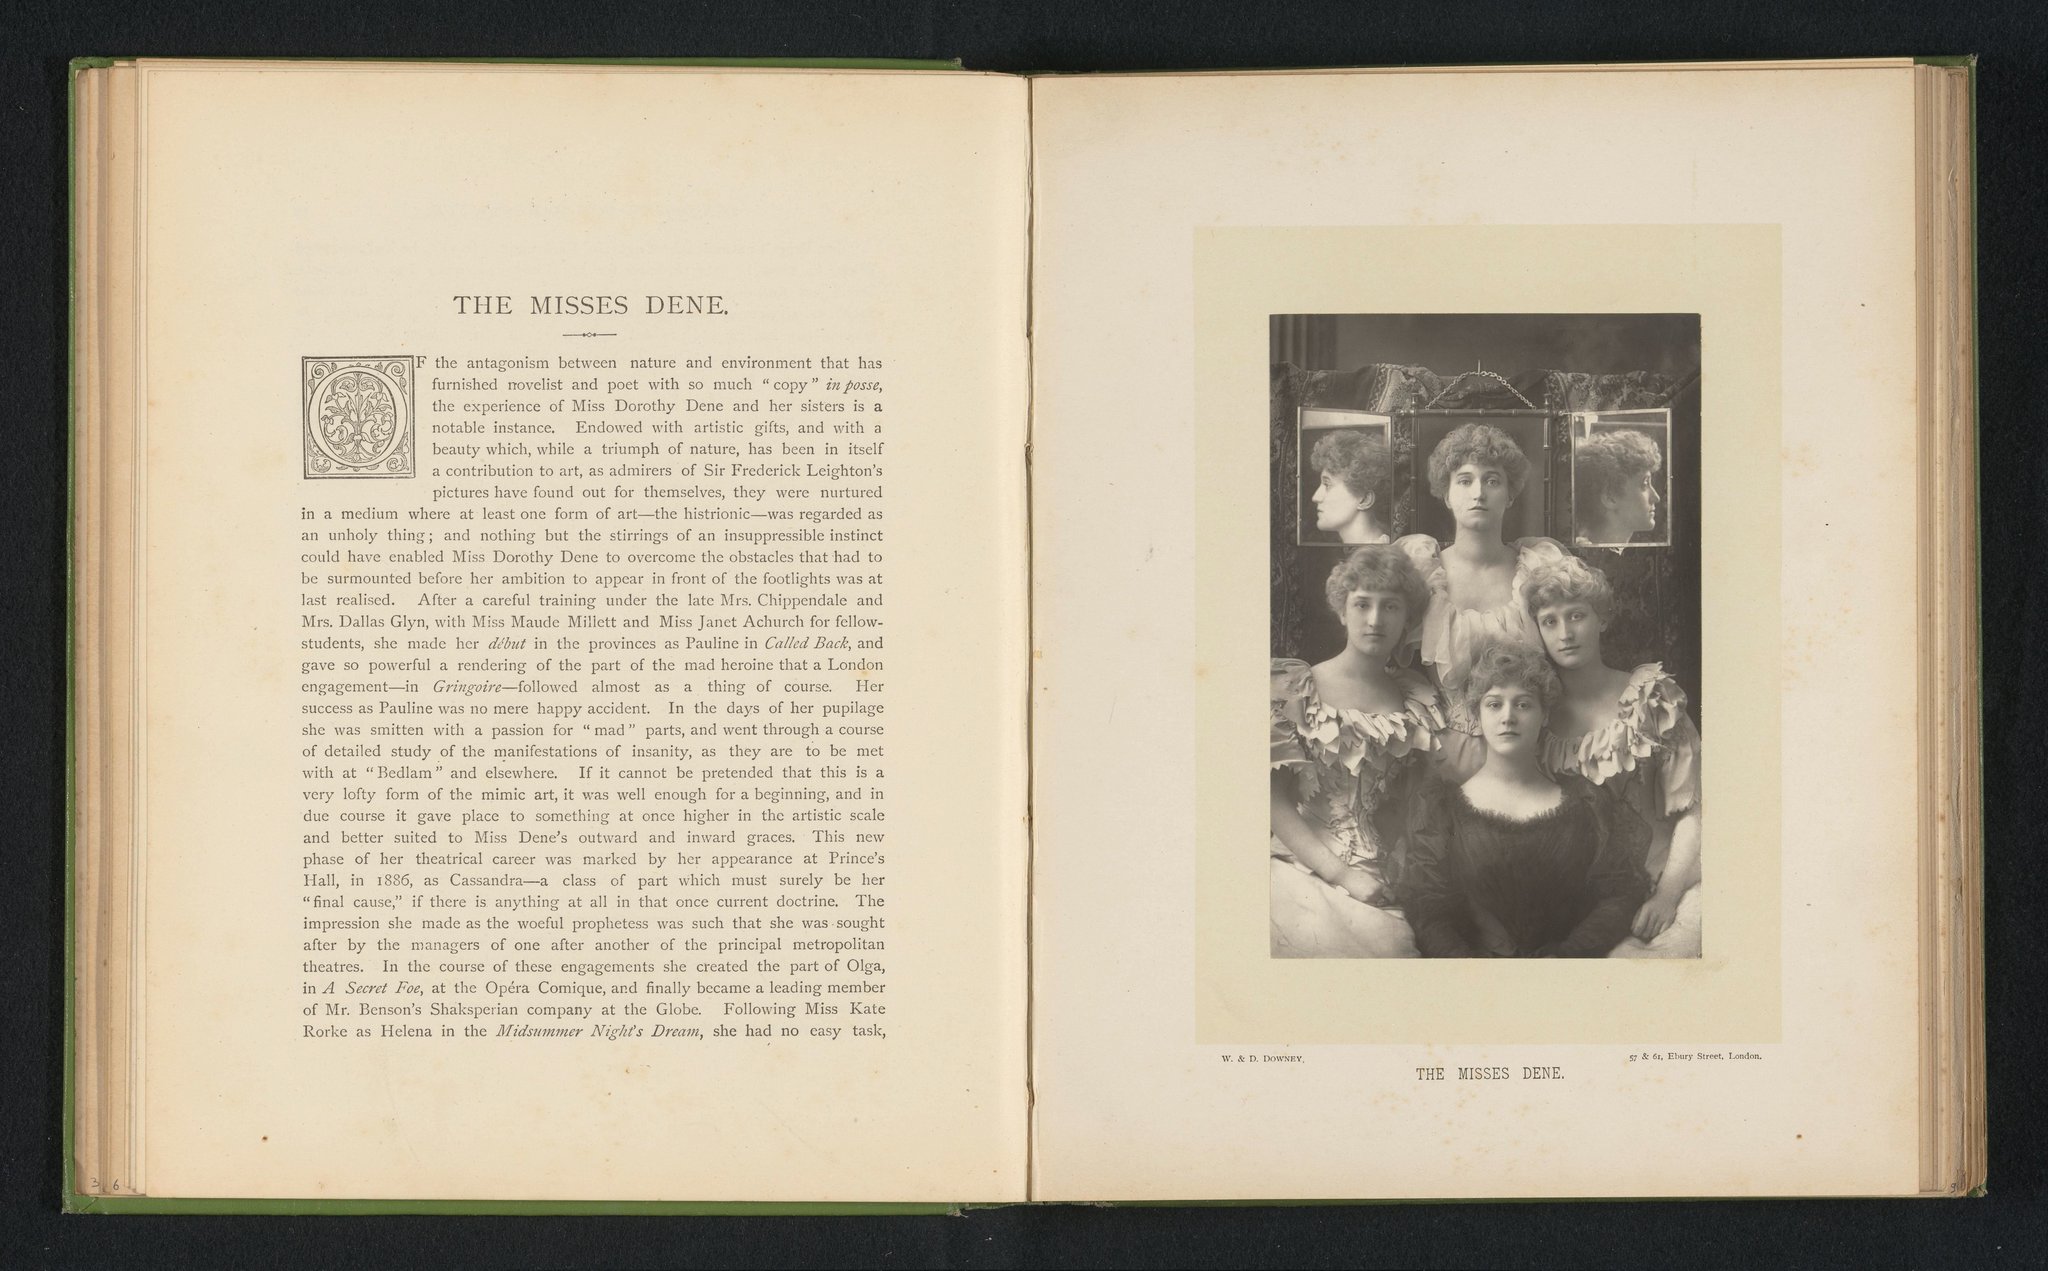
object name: page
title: The Misses Dene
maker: Anonymous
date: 1893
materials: paper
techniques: woodburytype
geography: london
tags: portrait of actor, actress, sisters (second degree family relationships)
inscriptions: inscription: ‘57 & 61, Elbury Street, London.’